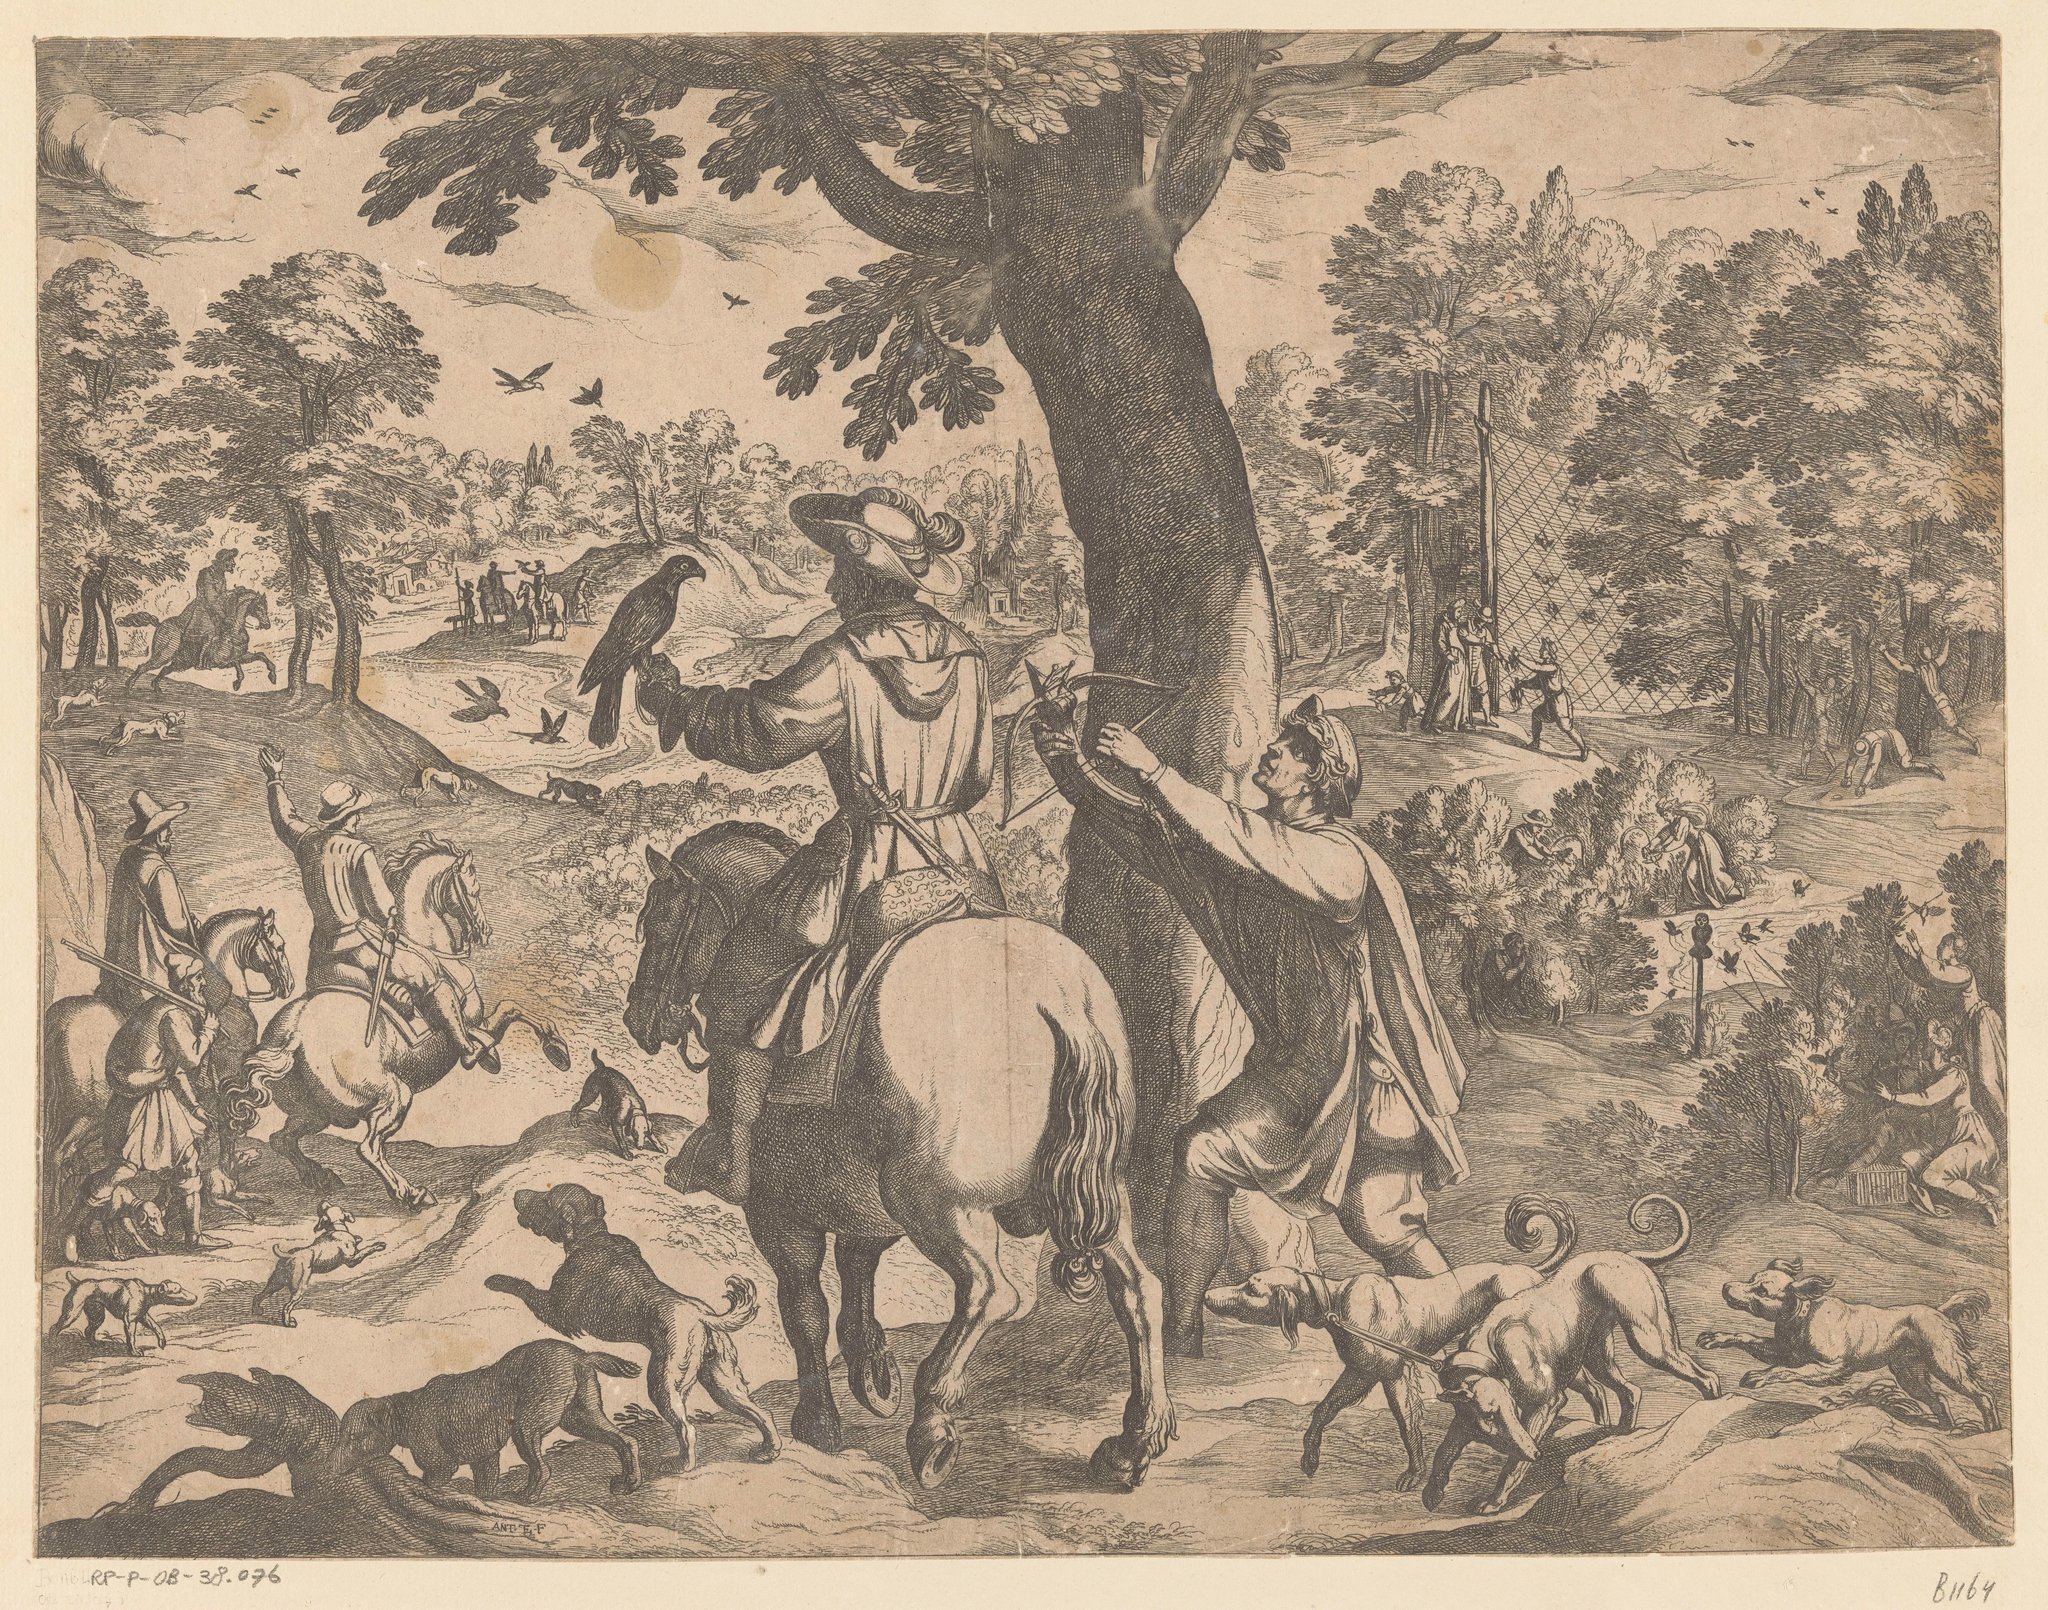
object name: print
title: Jacht met valken op vogels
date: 1599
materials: paper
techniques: etching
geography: rome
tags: predatory birds: falcon, hunter, hunters hunting (n.b.: in 1988-1990 this notation denoted the concept of 43c11421 'hunters resting during the hunt'), bird hunting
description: Landschap met jagers en jachthonden op vogeljacht. Op de voorgrond een jager te paard met een valk. Zijn assistent geeft hem zijn kruisboog.